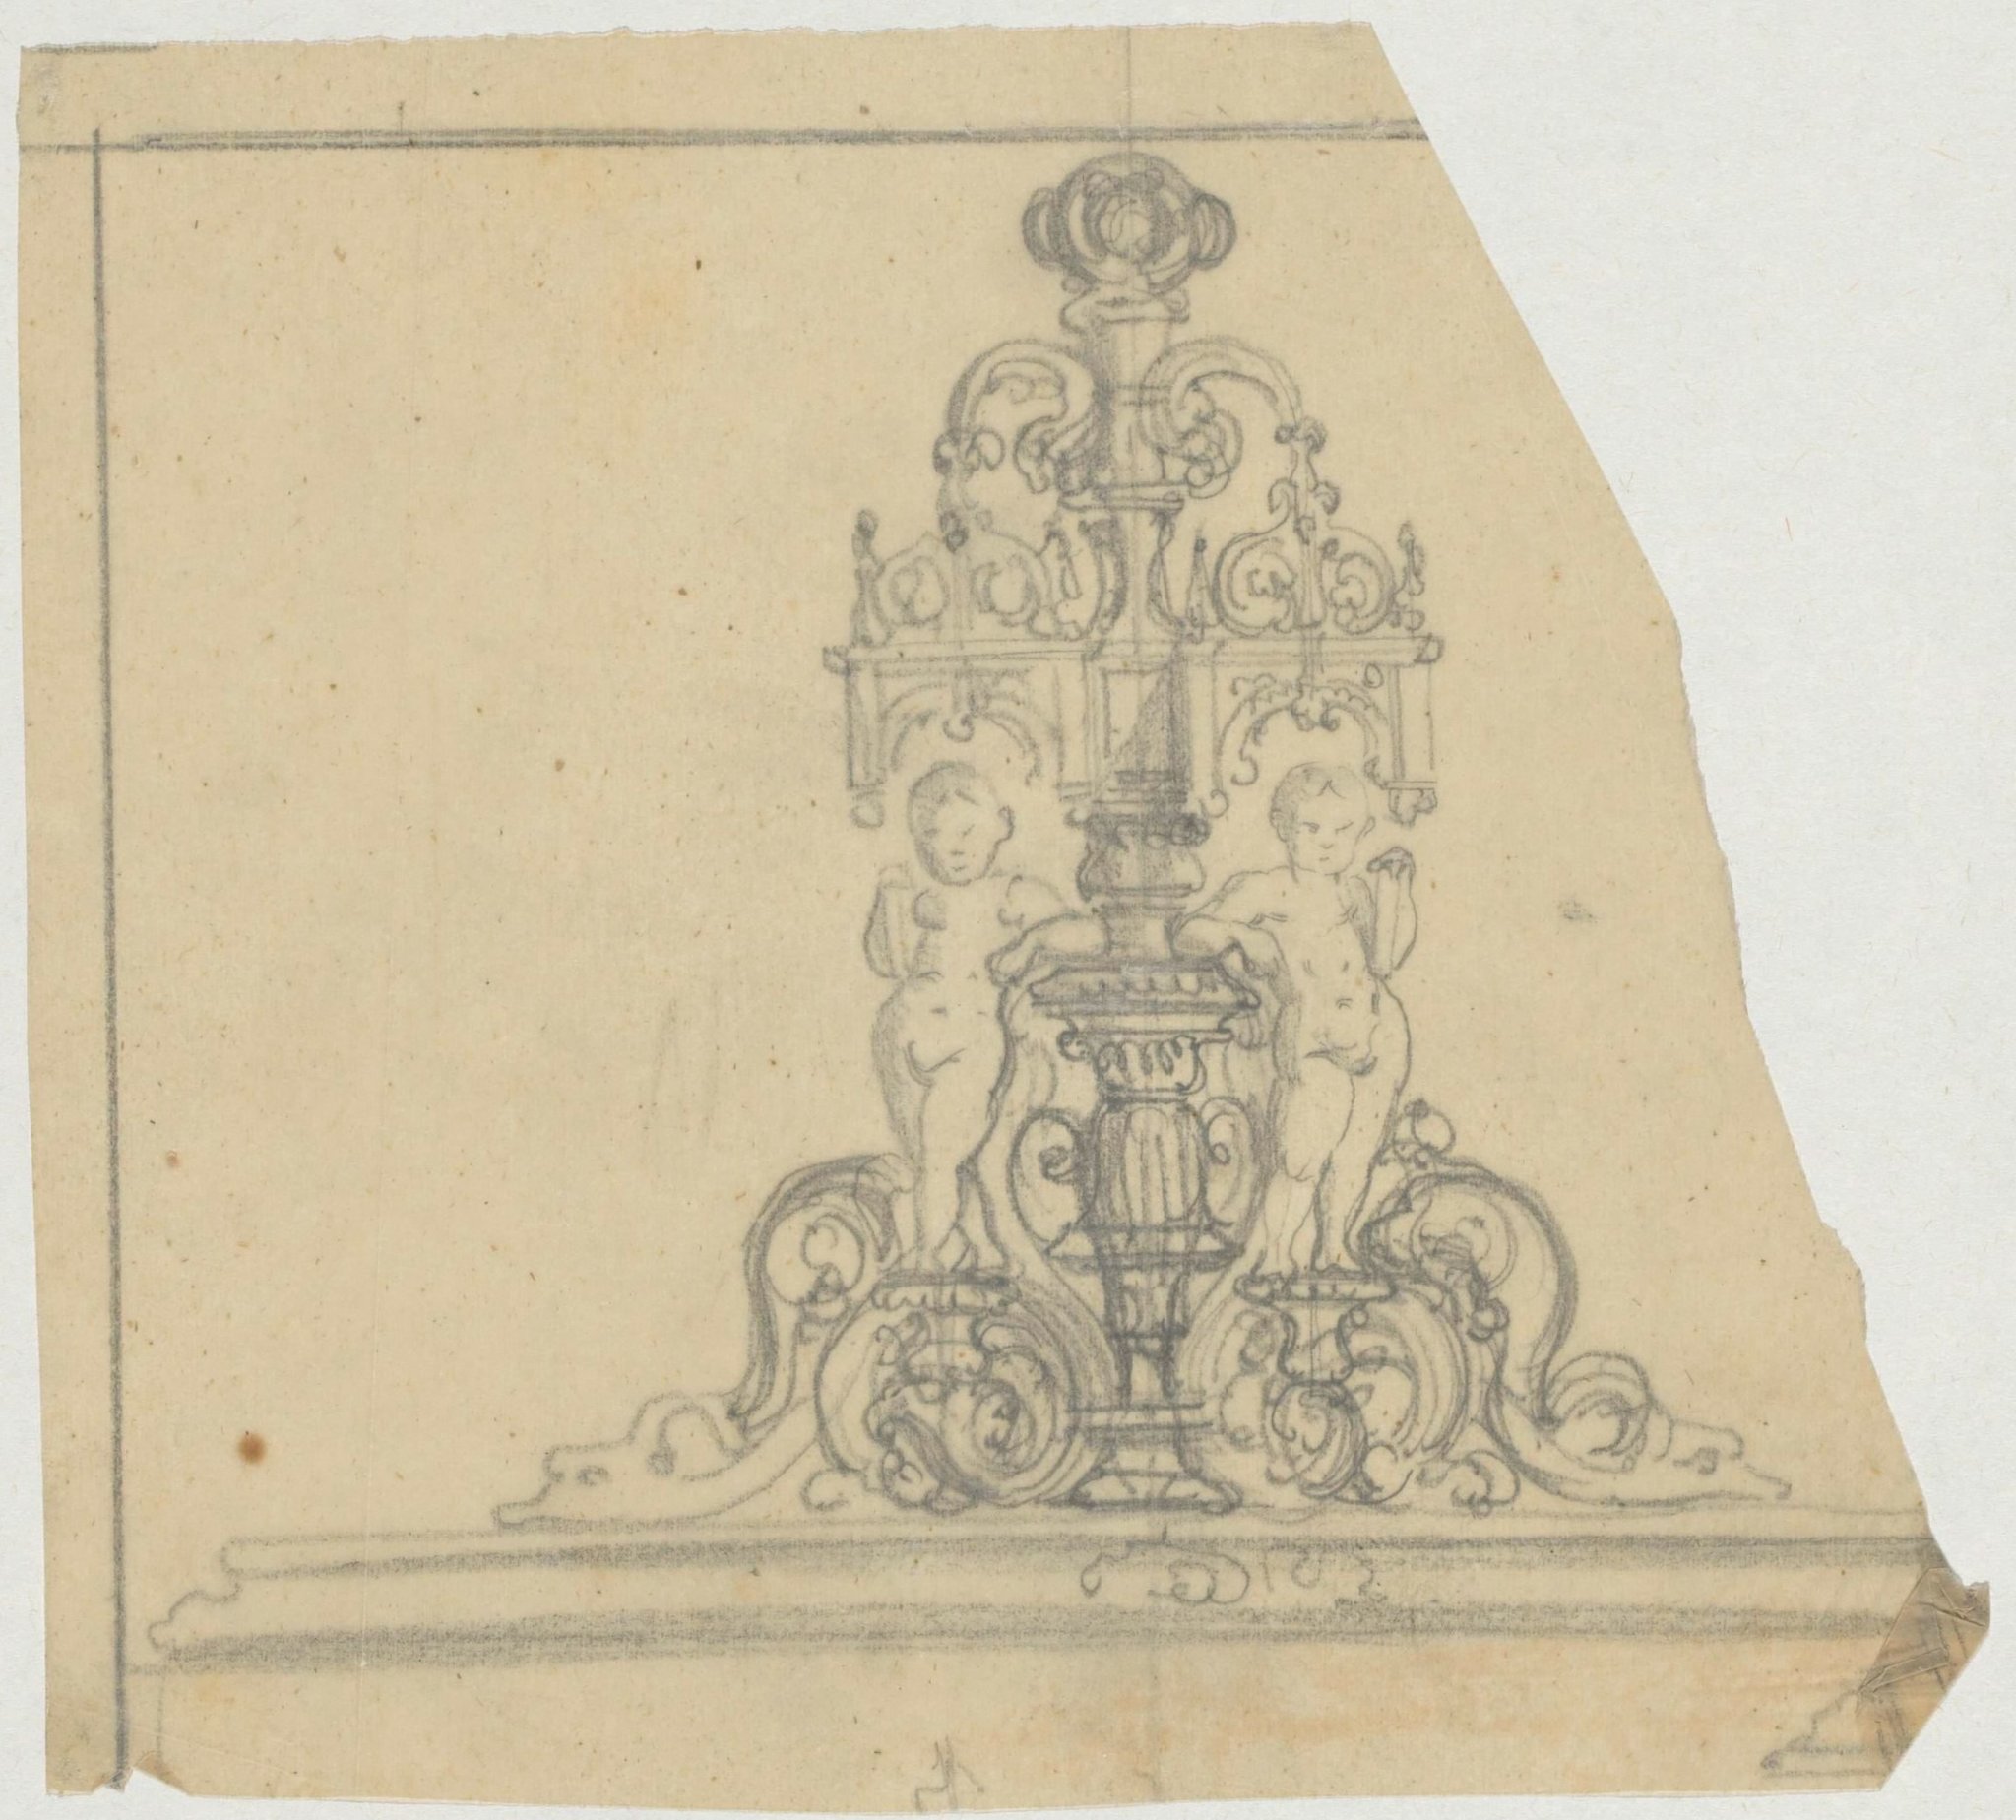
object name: design drawing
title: Vuurbok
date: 1830-1850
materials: graphite, paper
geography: paris